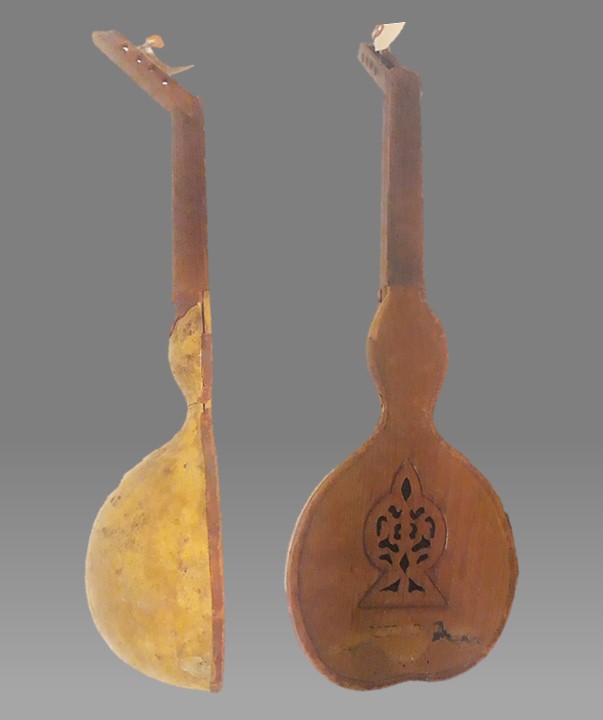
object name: quwaytara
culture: african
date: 1867-1900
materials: wood